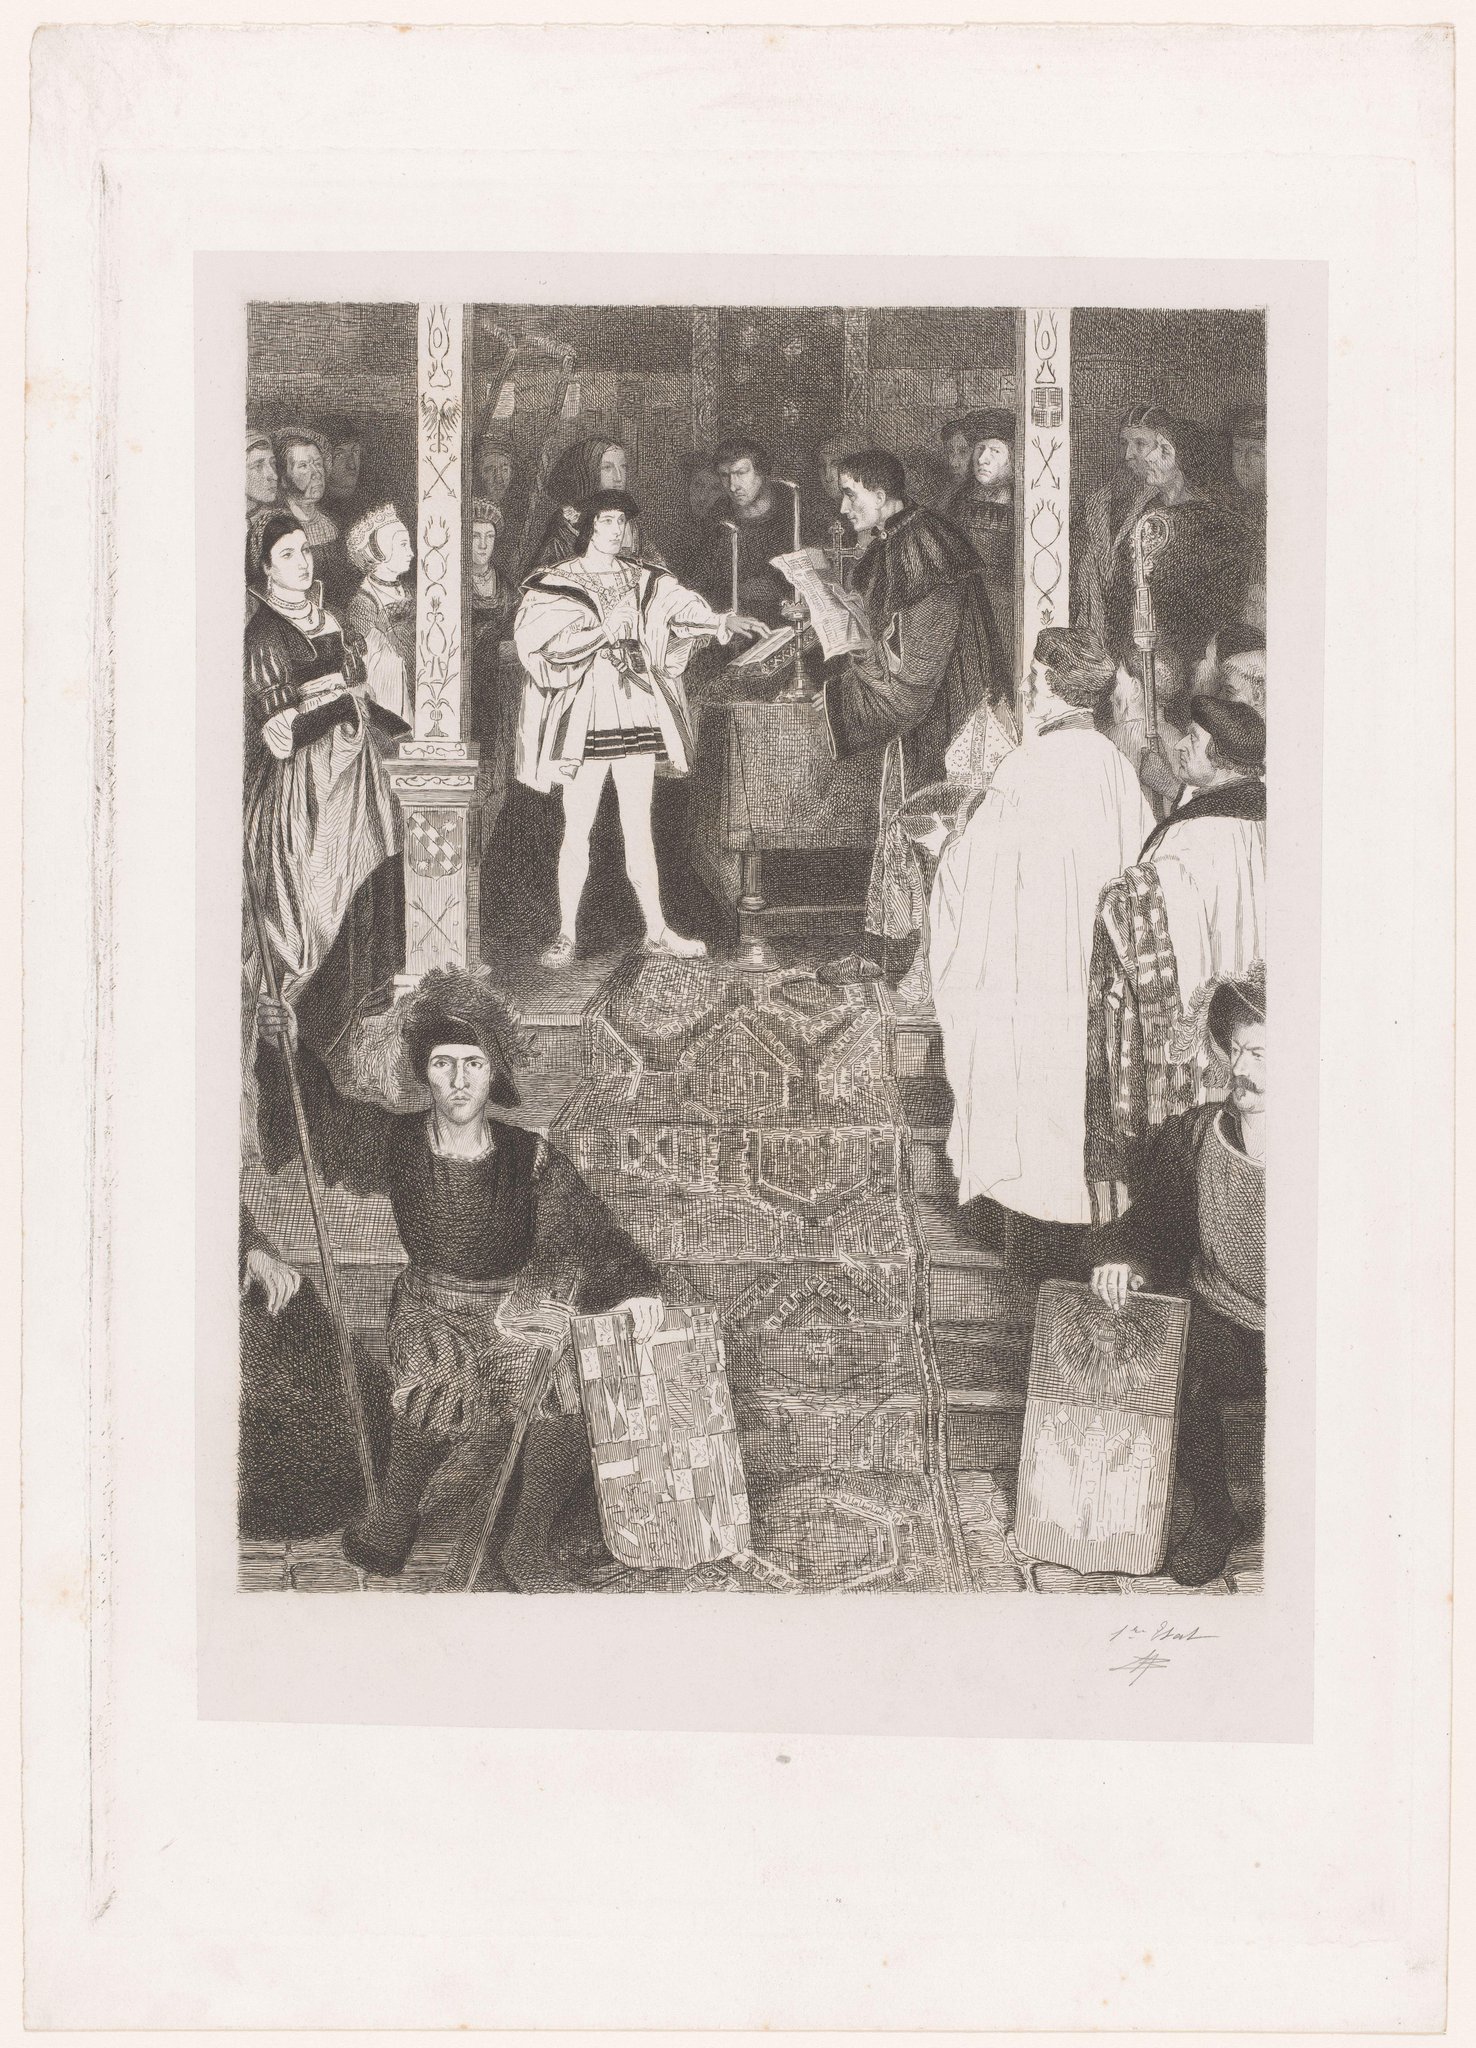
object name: print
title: Eedaflegging van keizer Karel V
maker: jean baptiste pierre michiels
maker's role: print maker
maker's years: 1821-1890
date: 1863-1890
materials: paper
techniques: etching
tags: charles v (holy roman emperor and king of spain), ceremonial celebration of installation of a ruler, new ruler taking the oath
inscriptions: inscription: ‘1e Etat’, collector's mark: Lugt 2228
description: De prent is gemaakt naar de muurschilderingen van Henri Leys in het Stadhuis van Antwerpen. Een latere staat van de plaat is gebruikt in: Leys, Henri. De Zaal Leys op het Stadhuis van Antwerpen: zeven kopersneden naar de muurschilderingen van Baron H. Leys. Antwerpen: Museum Plantin-Moretus, 1902.